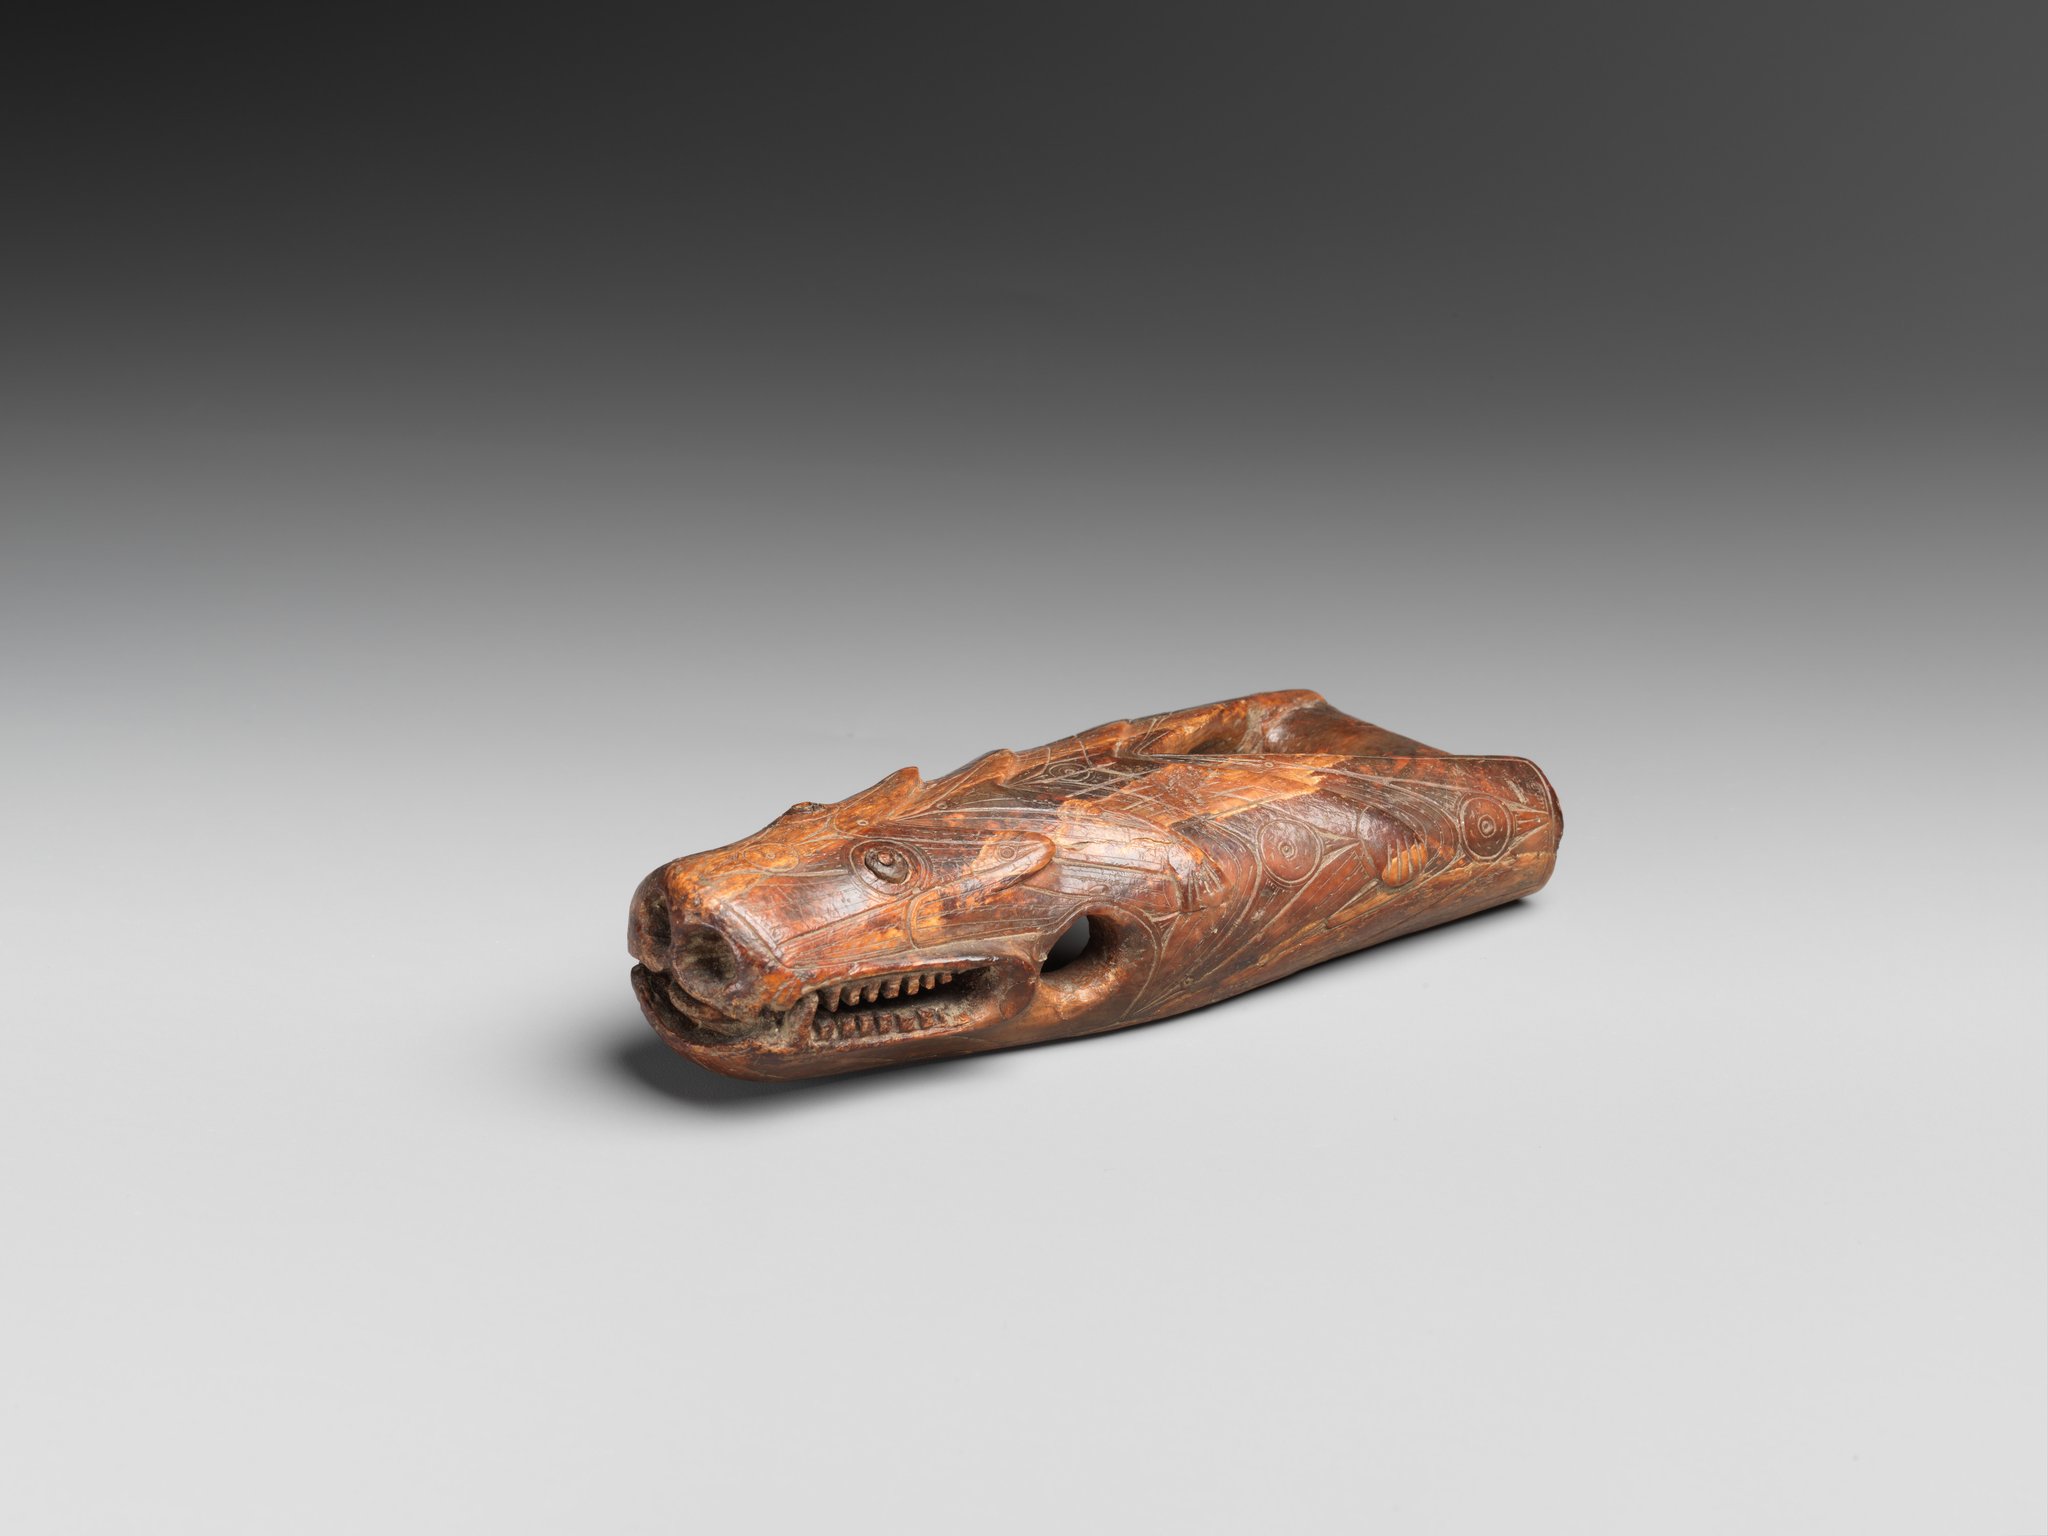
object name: toggle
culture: okvik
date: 100 BCE-200 CE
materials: ivory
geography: united states